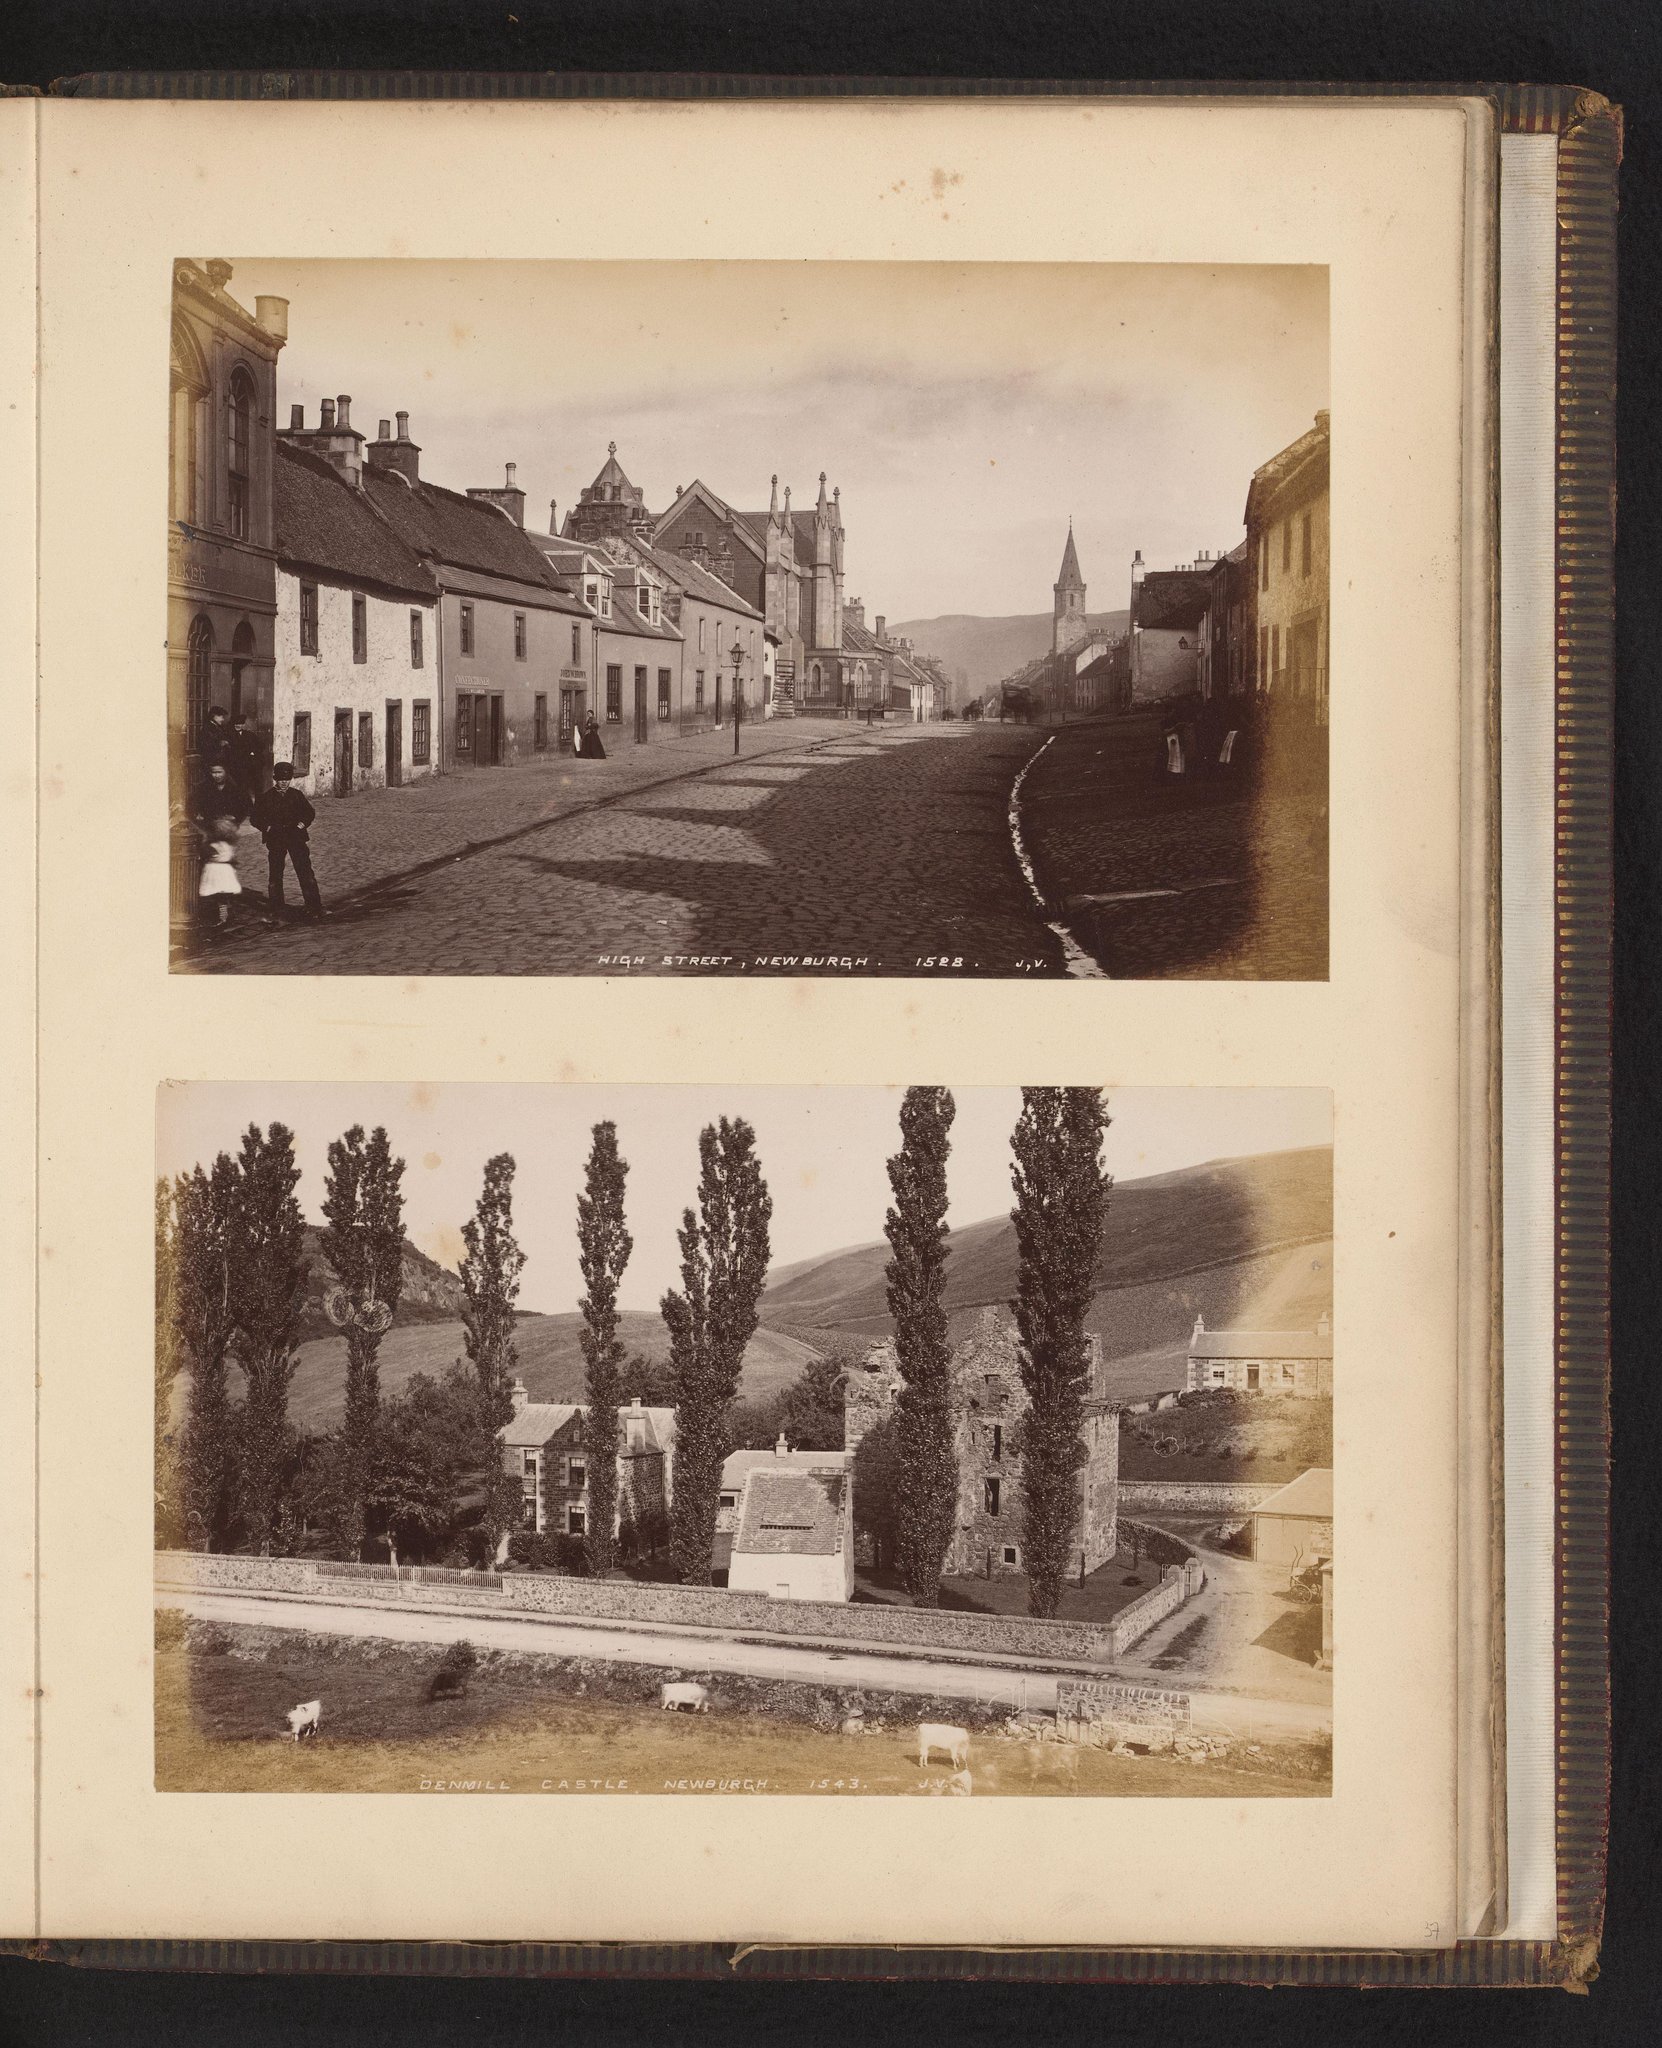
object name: photograph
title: High Street, Newburgh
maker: Anonymous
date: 1875-1885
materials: photographic support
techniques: albumen print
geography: scotland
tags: castle, street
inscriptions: number: ‘1528, J.V.’, number: ‘1543, J.V.’